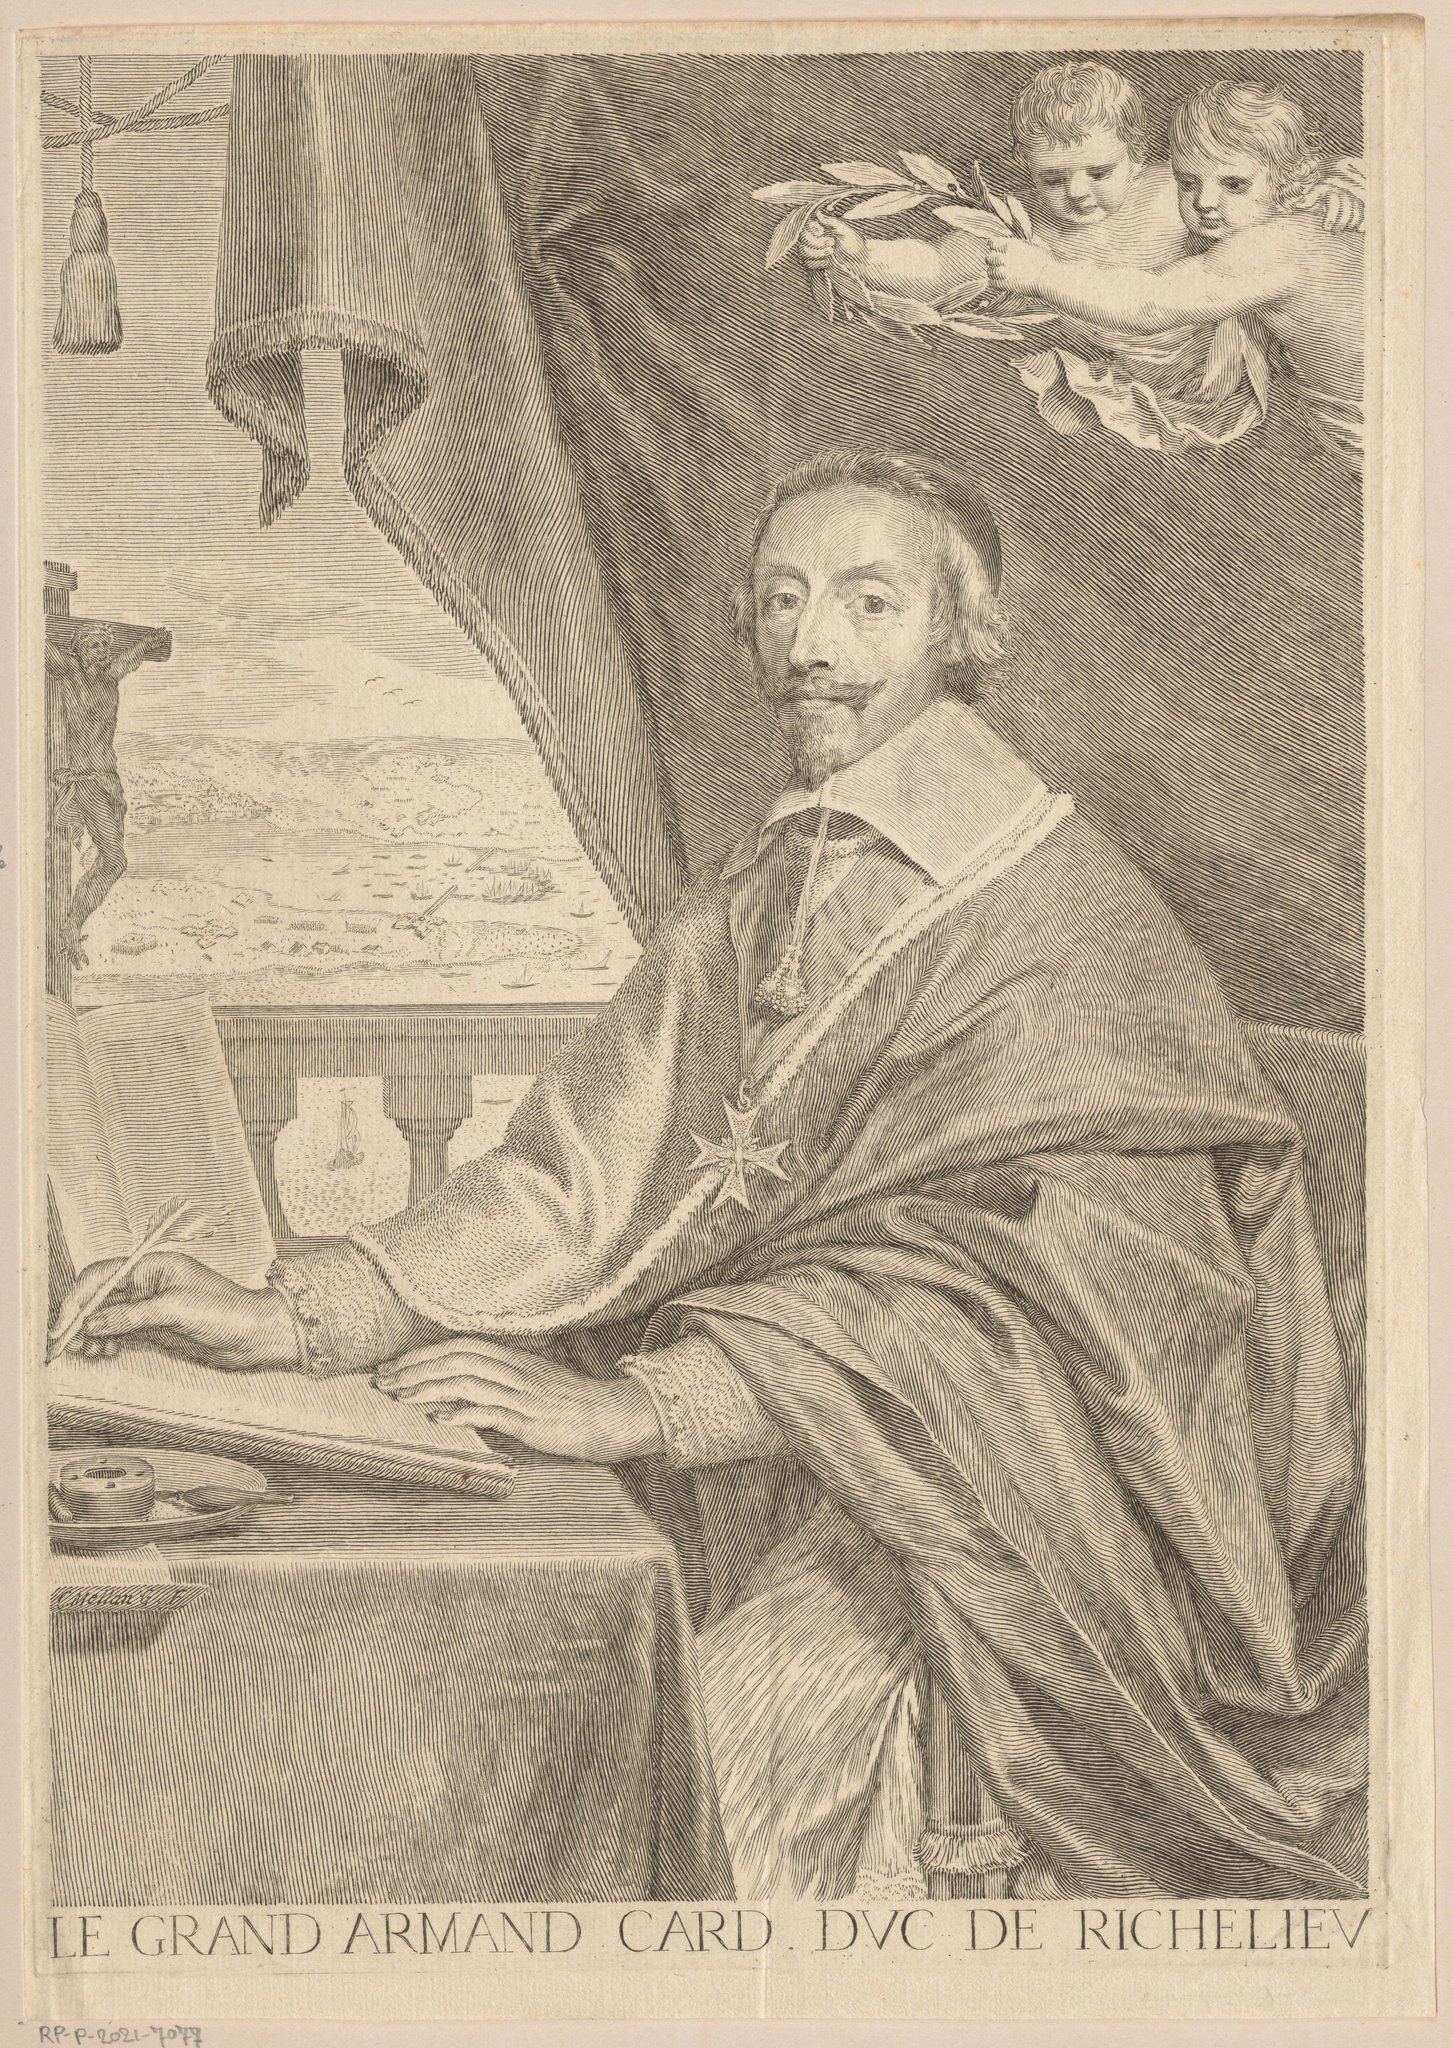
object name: print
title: Portret van Armand-Jean du Plessis hertog van Richelieu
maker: claude mellan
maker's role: draughtsman, print maker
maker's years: 1598-1688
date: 1608-1688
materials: paper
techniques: engraving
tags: paris, armand-jean du plessis hertog van richelieu, historical persons, cupids: 'amores', 'amoretti', 'putti'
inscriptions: inscription: ‘KB’